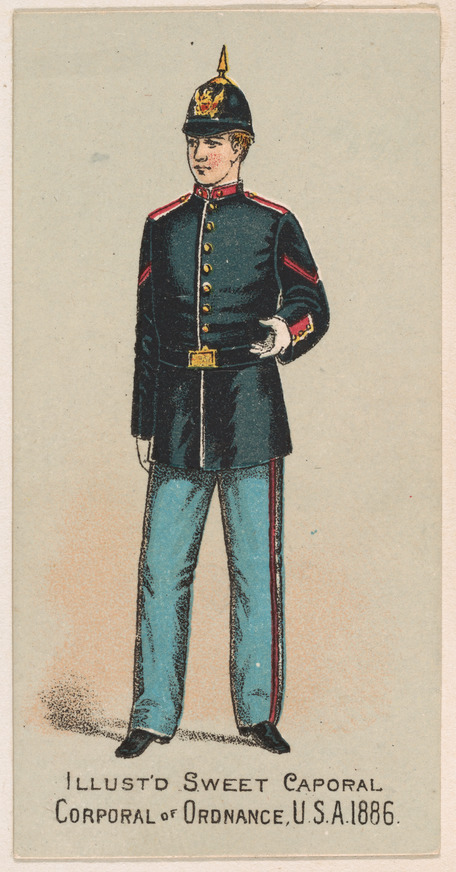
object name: print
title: Corporal of Ordnance, United States Army, 1886, from the Military Series (N224) issued by Kinney Tobacco Company to promote Sweet Caporal Cigarettes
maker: kinney brothers tobacco company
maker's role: publisher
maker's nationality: american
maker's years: 1869-2011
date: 1888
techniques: color lithograph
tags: military,men